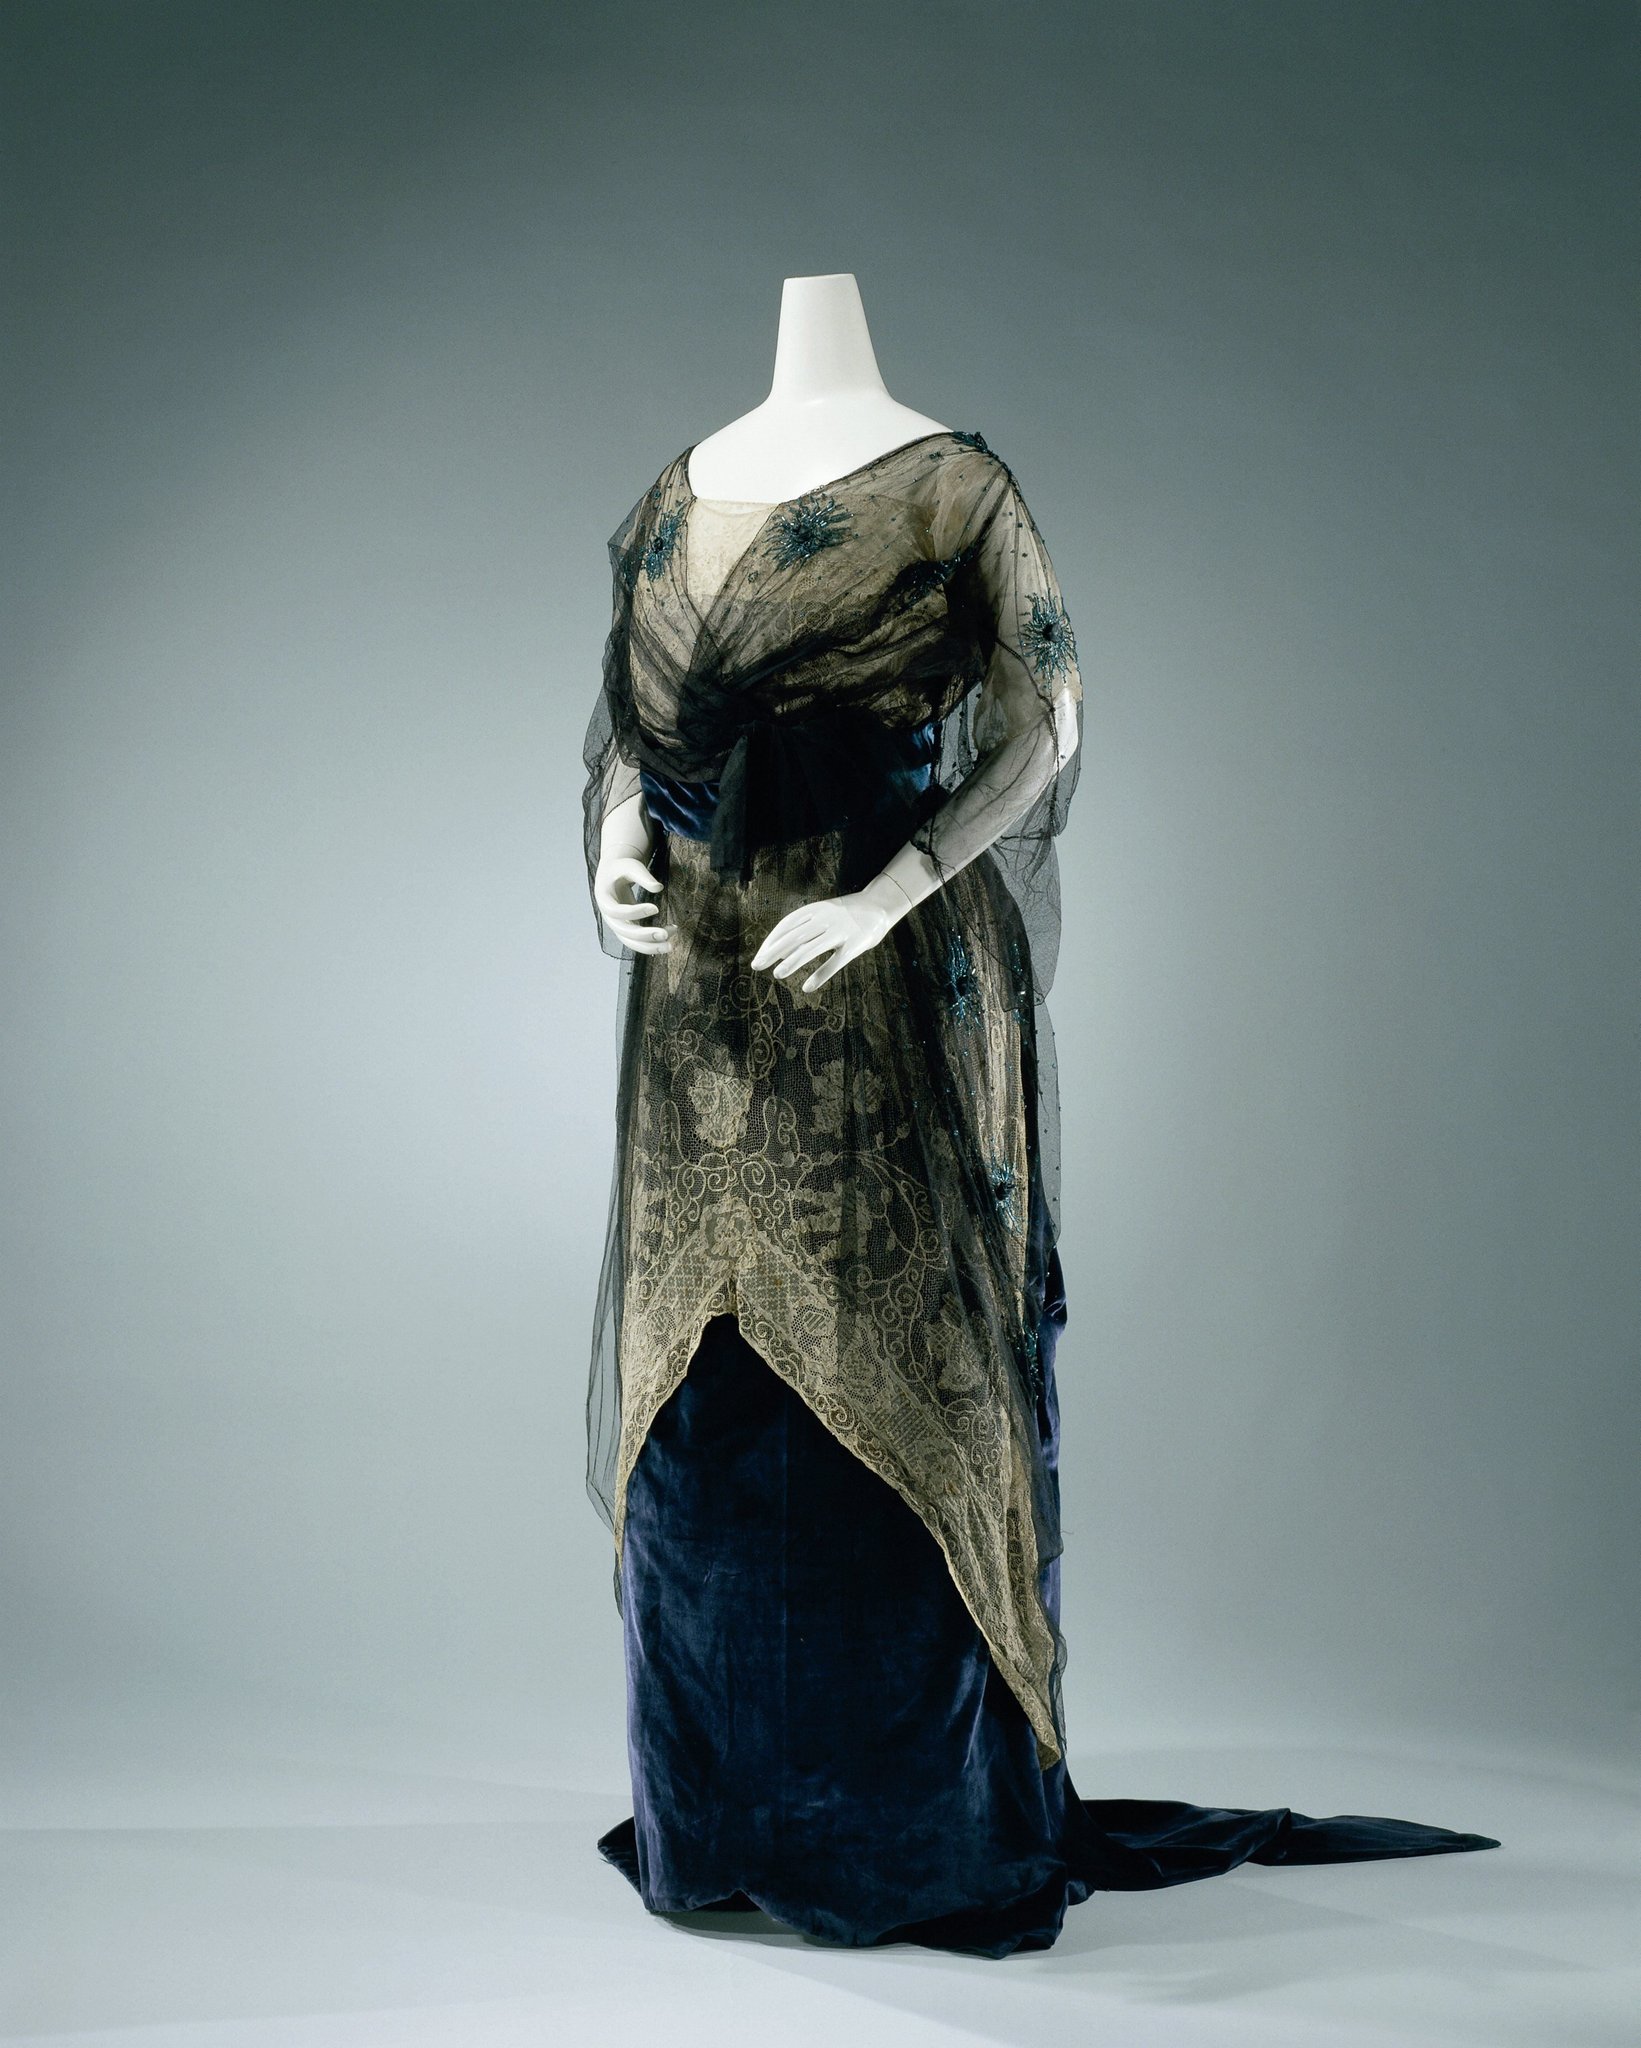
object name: womenswear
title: Japon van blauwgroene velours chiffon en zalmkleurige zijde, waarover machinale kant en zwarte tule met blauwgroen kralenborduursel, bestaande uit een lijf (a) en rok (b).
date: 1912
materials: fiber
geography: paris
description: Japon van blauwgroene velours chiffon waarover machinale kant en zwarte tule met blauwgroen kralenborduursel, zgn. strompeljapon. Voor rechte halsuitsnijding, achter V-hals, halflange mouwen, hoge taille. Rok uitlopend in klein sleepje. Hier overheen machinale kanten rok. Brede tailleband. Zalmkleurig zijden onderlijfje in hemdmodel waarover tule met kant. Brede tailleband die asymmetrisch uitloopt naar de rechter schouder. Voeringlijfje is afgezet met kant. Over lijfje en rok een overjapon van zwarte tule met kralenborduursel. Sachet met opschrift "D'ORSAY...,12 RUE DE LA PAIX, PARIS, LES ROSES D'ARSAY" Adres: Hirsch & Cie., Amsterdam.